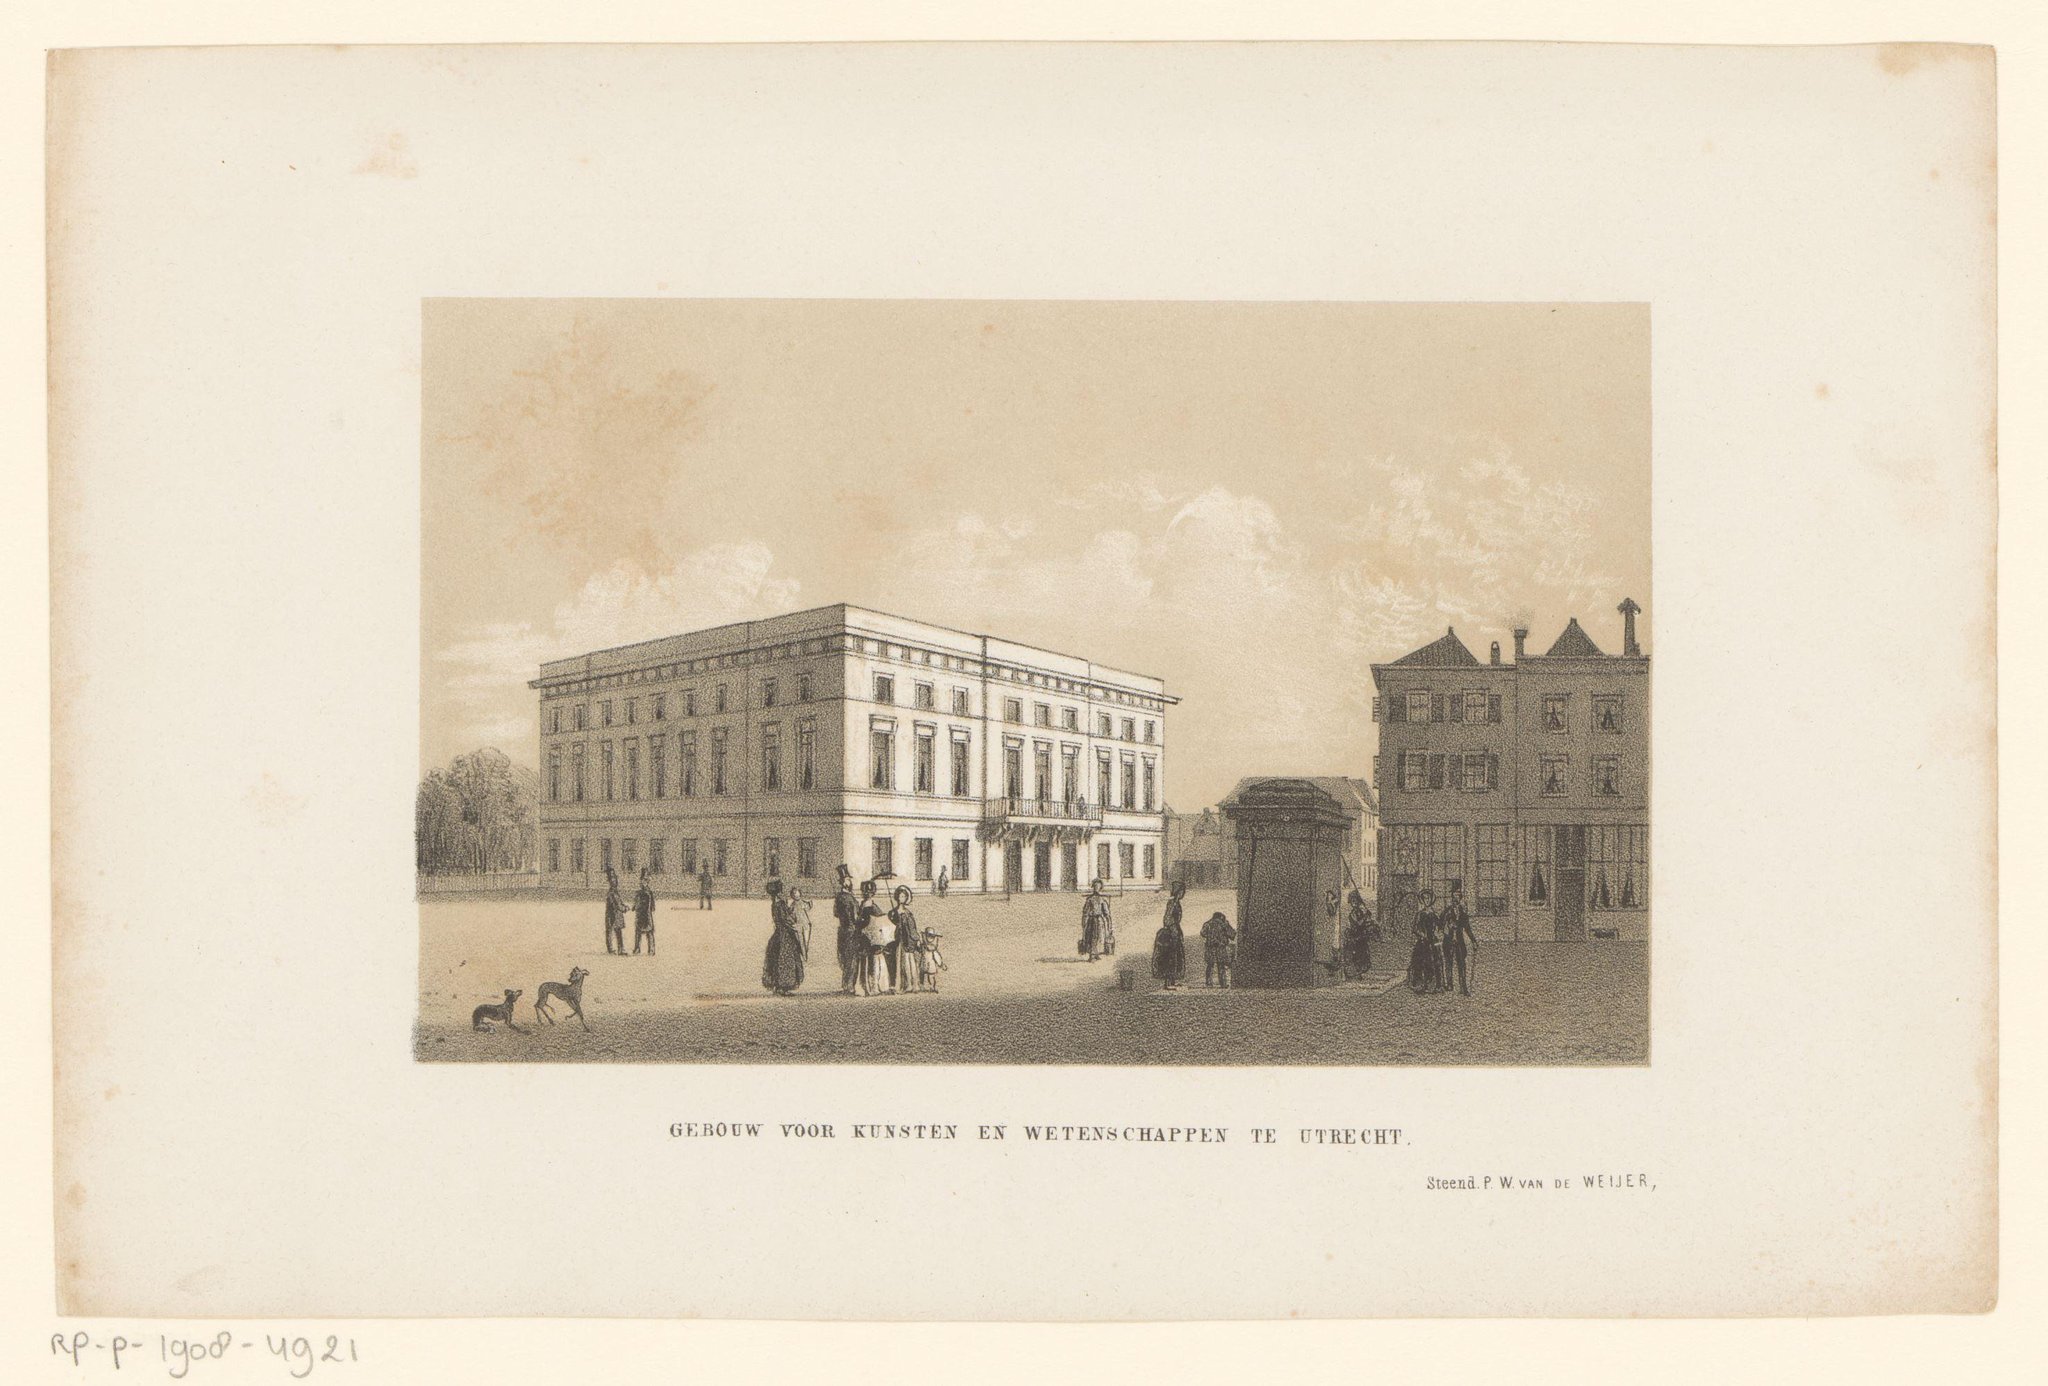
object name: print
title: Gebouw voor kunsten en wetenschappen te Utrecht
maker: pieter wilhelmus van de weijer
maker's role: print maker, printer, publisher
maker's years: 1816-1880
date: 1856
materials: paper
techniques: tone lithography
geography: utrecht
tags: city-view, and landscape with man-made constructions, pump, concert hall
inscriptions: collector's mark: Lugt 2228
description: Mogelijk maakte deze prent deel uit van: Utrecht's Album, Utrecht: W.F.Dannenfelser, 1856.